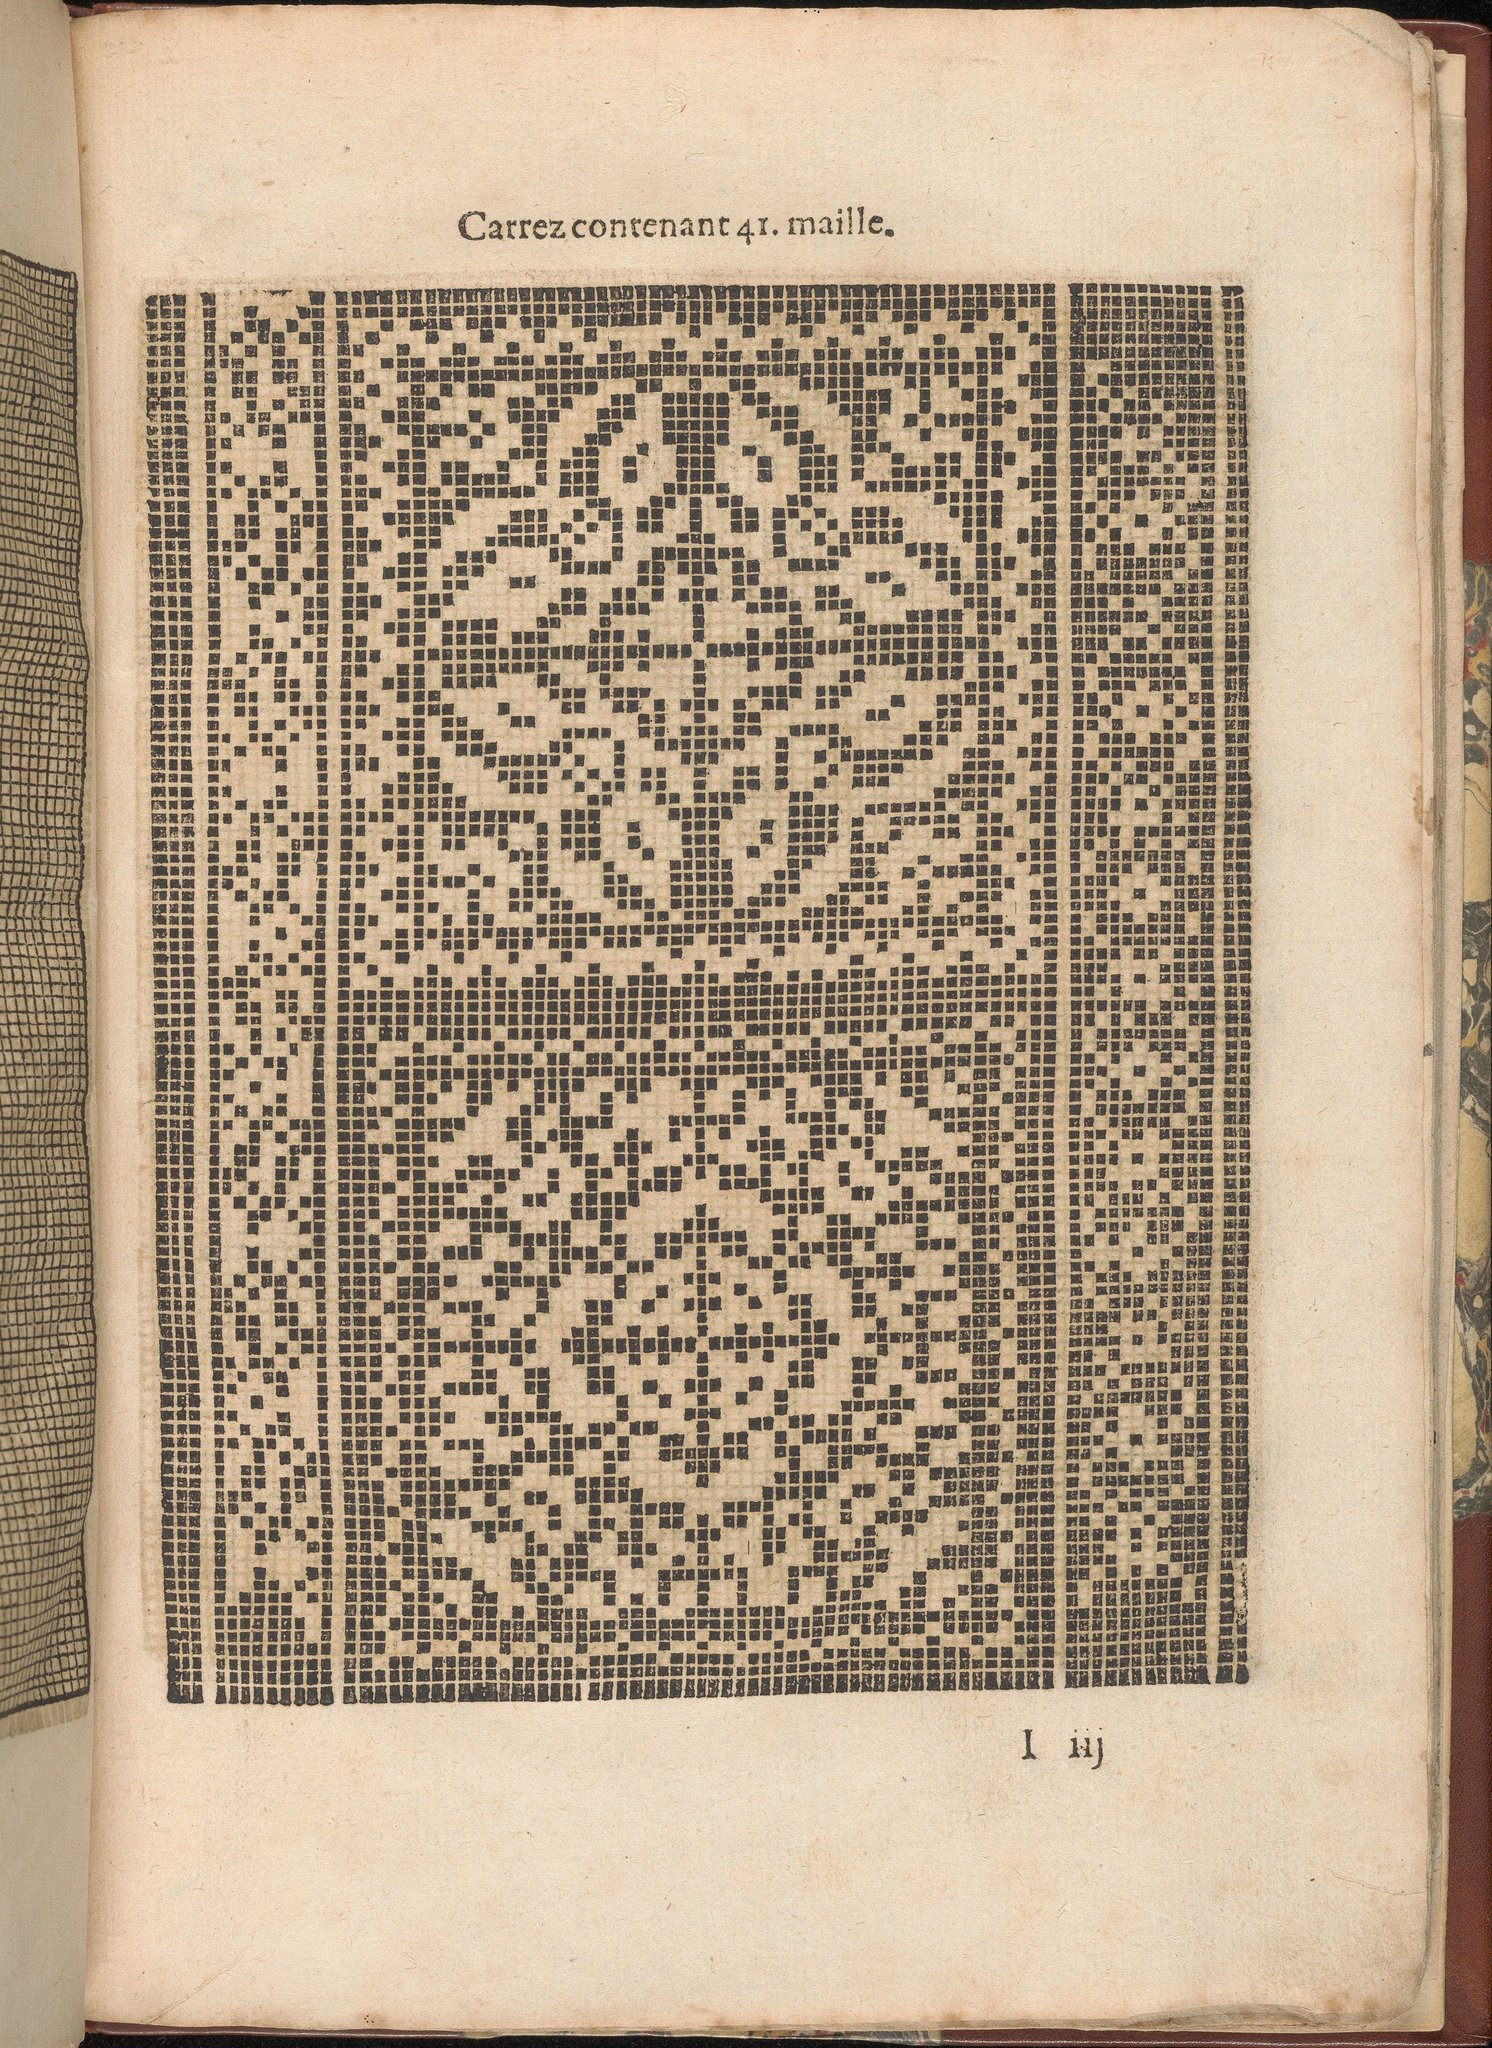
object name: book print ornament architecture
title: Les Secondes Oeuvres, et Subtiles Inventions De Lingerie du Seigneur Federic de Vinciolo Venitien, page 35 (recto)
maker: federico de vinciolo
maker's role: designer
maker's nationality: italian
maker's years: 1582-1599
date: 1603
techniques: woodcut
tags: ornament